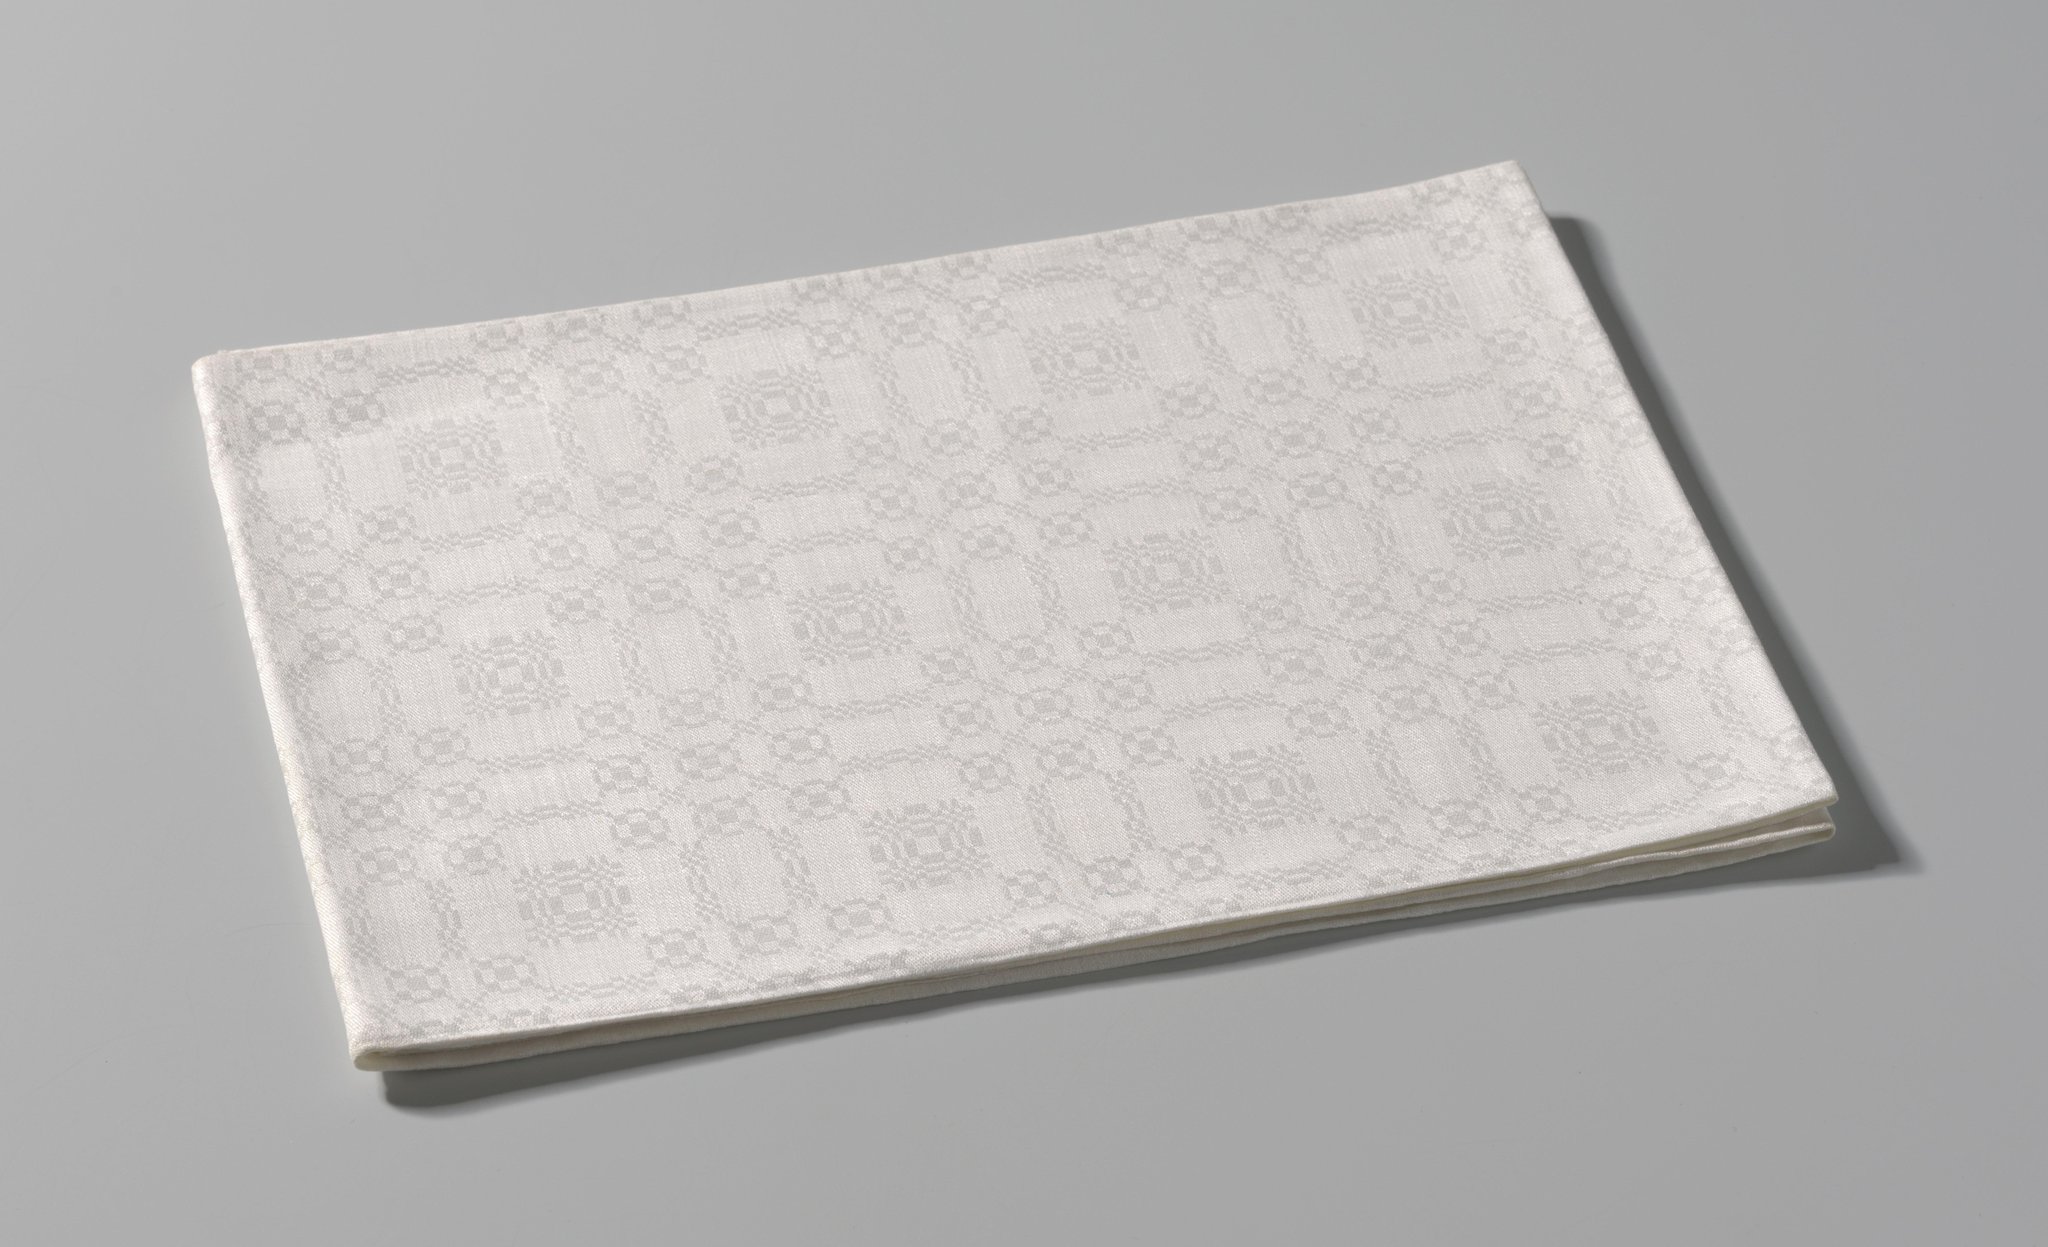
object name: napkin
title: Servet van linnen met pellenpatroon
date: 1680-1710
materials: linen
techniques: peeled fabric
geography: northern netherlands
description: Wit linnen servet met een pellen patroon. Merk HW.